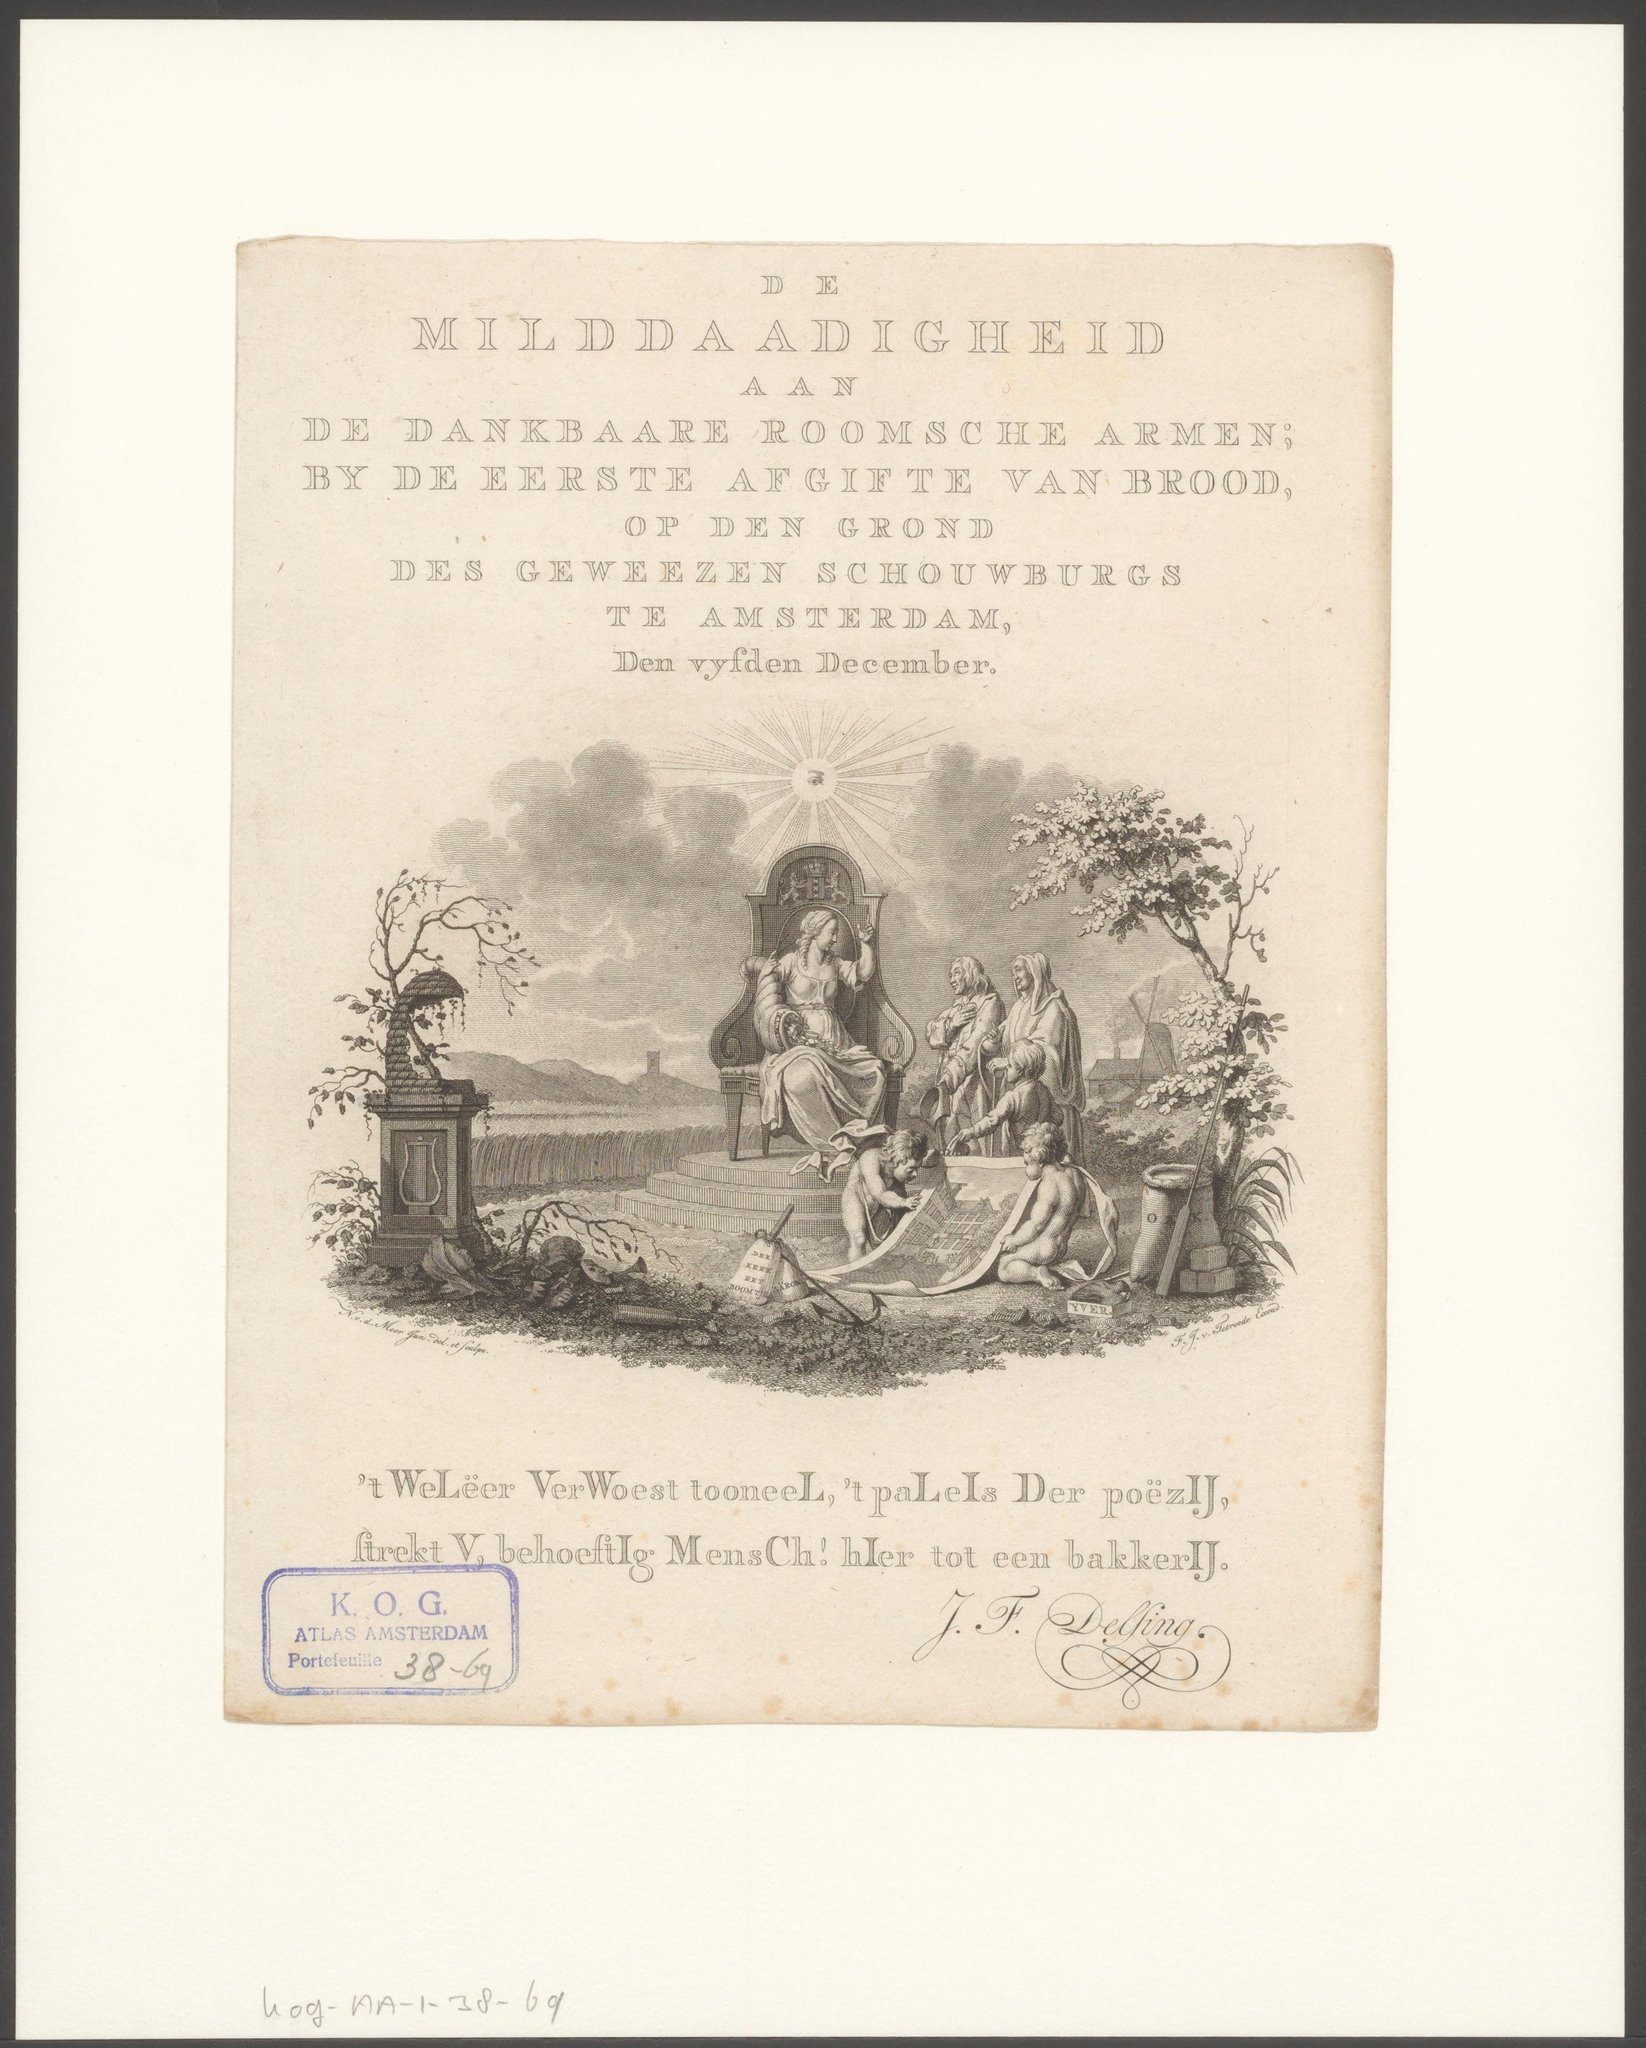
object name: print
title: De Milddaadigheid aan de dankbaare roomsche armen; by de eerste afgifte van brood, op den grond des geweezen schouwburgs te Amsterdam, Den vyfden December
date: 1787-1788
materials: paper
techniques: engraving, etching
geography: northern netherlands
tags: generosity, liberality; 'generosità', 'liberalità' (ripa) (+ abstract concept represented by female figure)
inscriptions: collector's mark: Lugt 1641b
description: Onderwerpsrubriek binnen de Atlas Amsterdam: Armwezen en liefdadige instellingen: II. Kerkelijke inrichtingen: Inrichtingen der Roomsch-Katholieken.